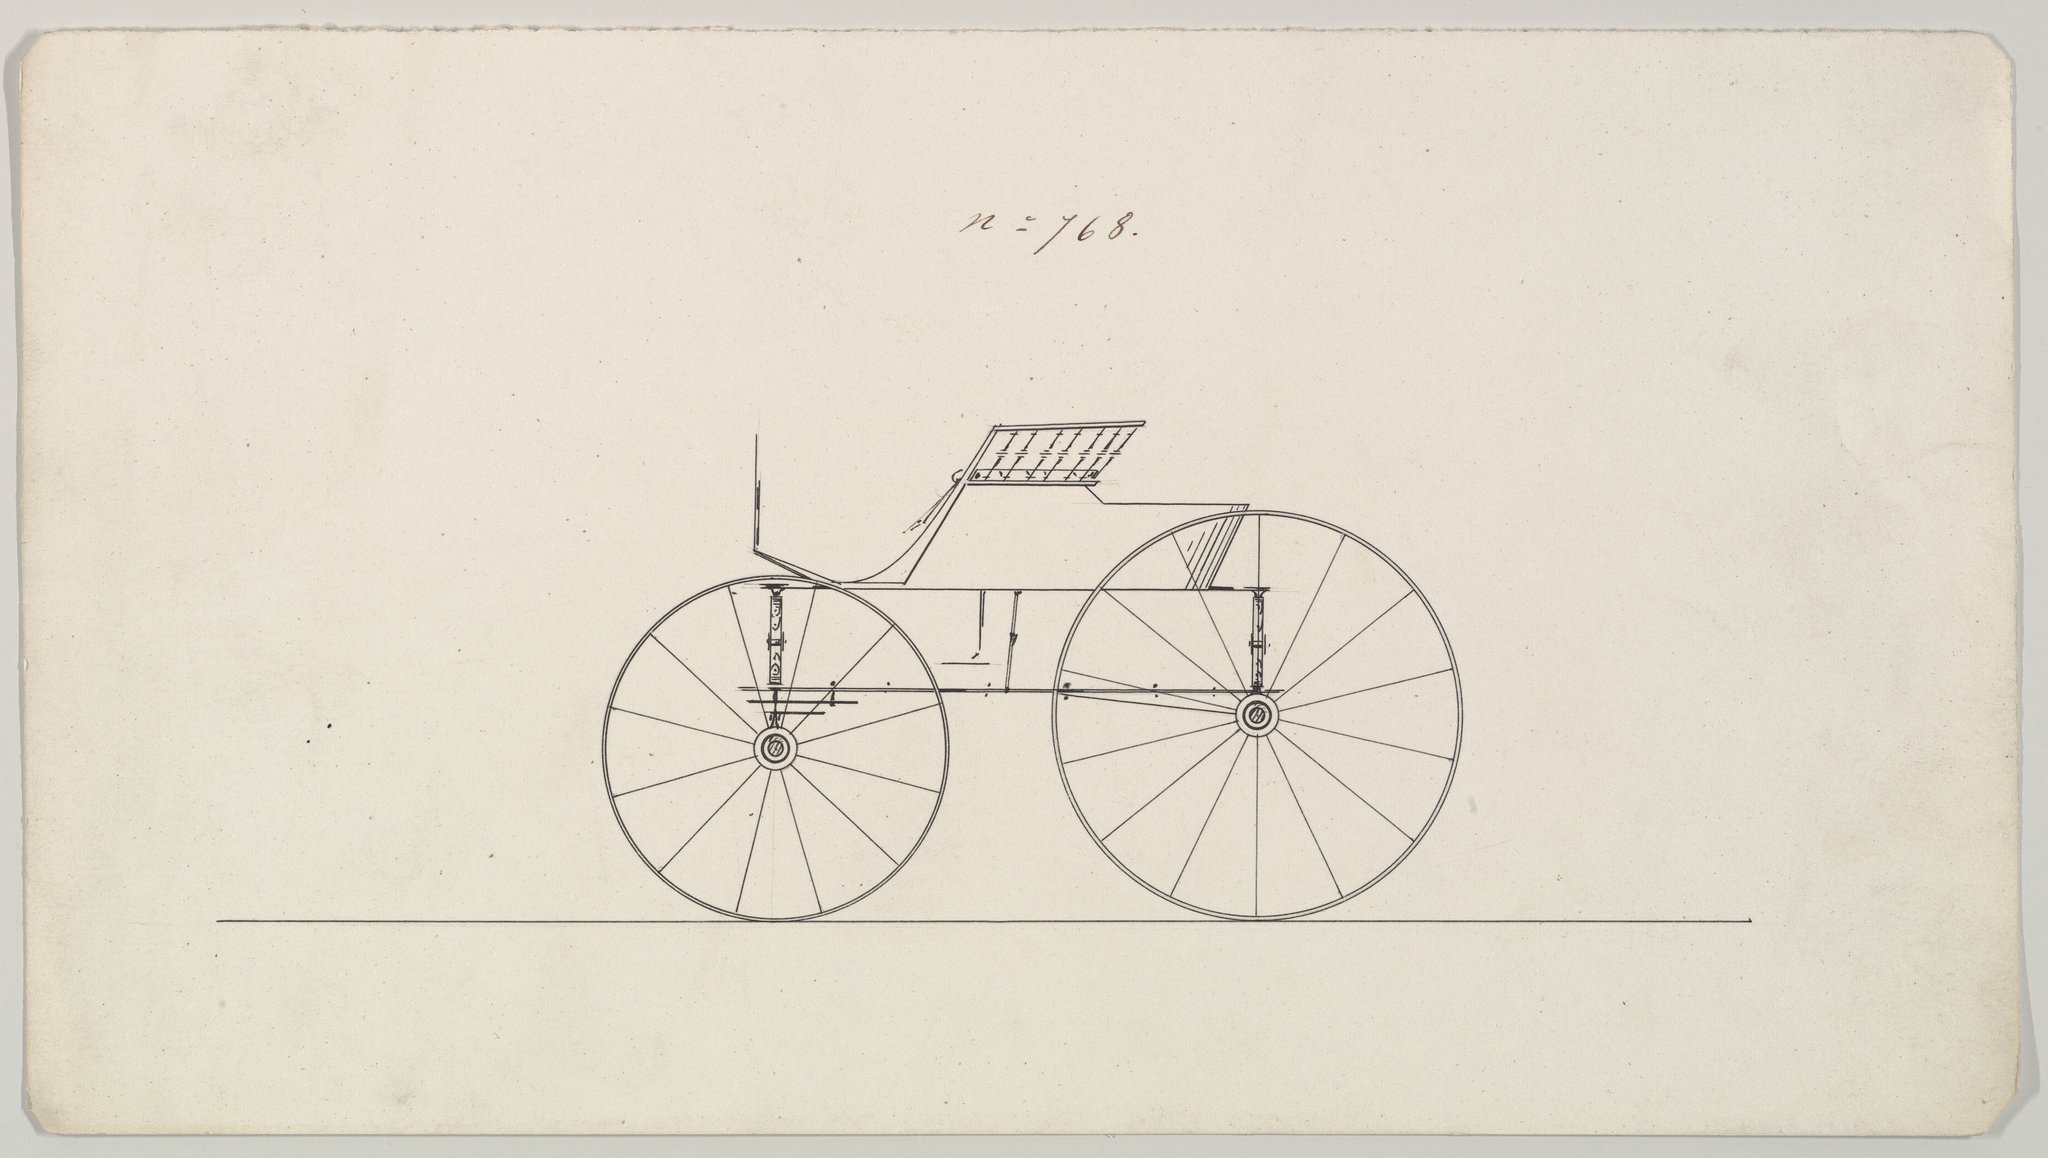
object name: drawing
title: Design for Wagon, no. 768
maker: brewster & co.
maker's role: manufacturer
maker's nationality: american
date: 1860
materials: ink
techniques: pen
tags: carriages